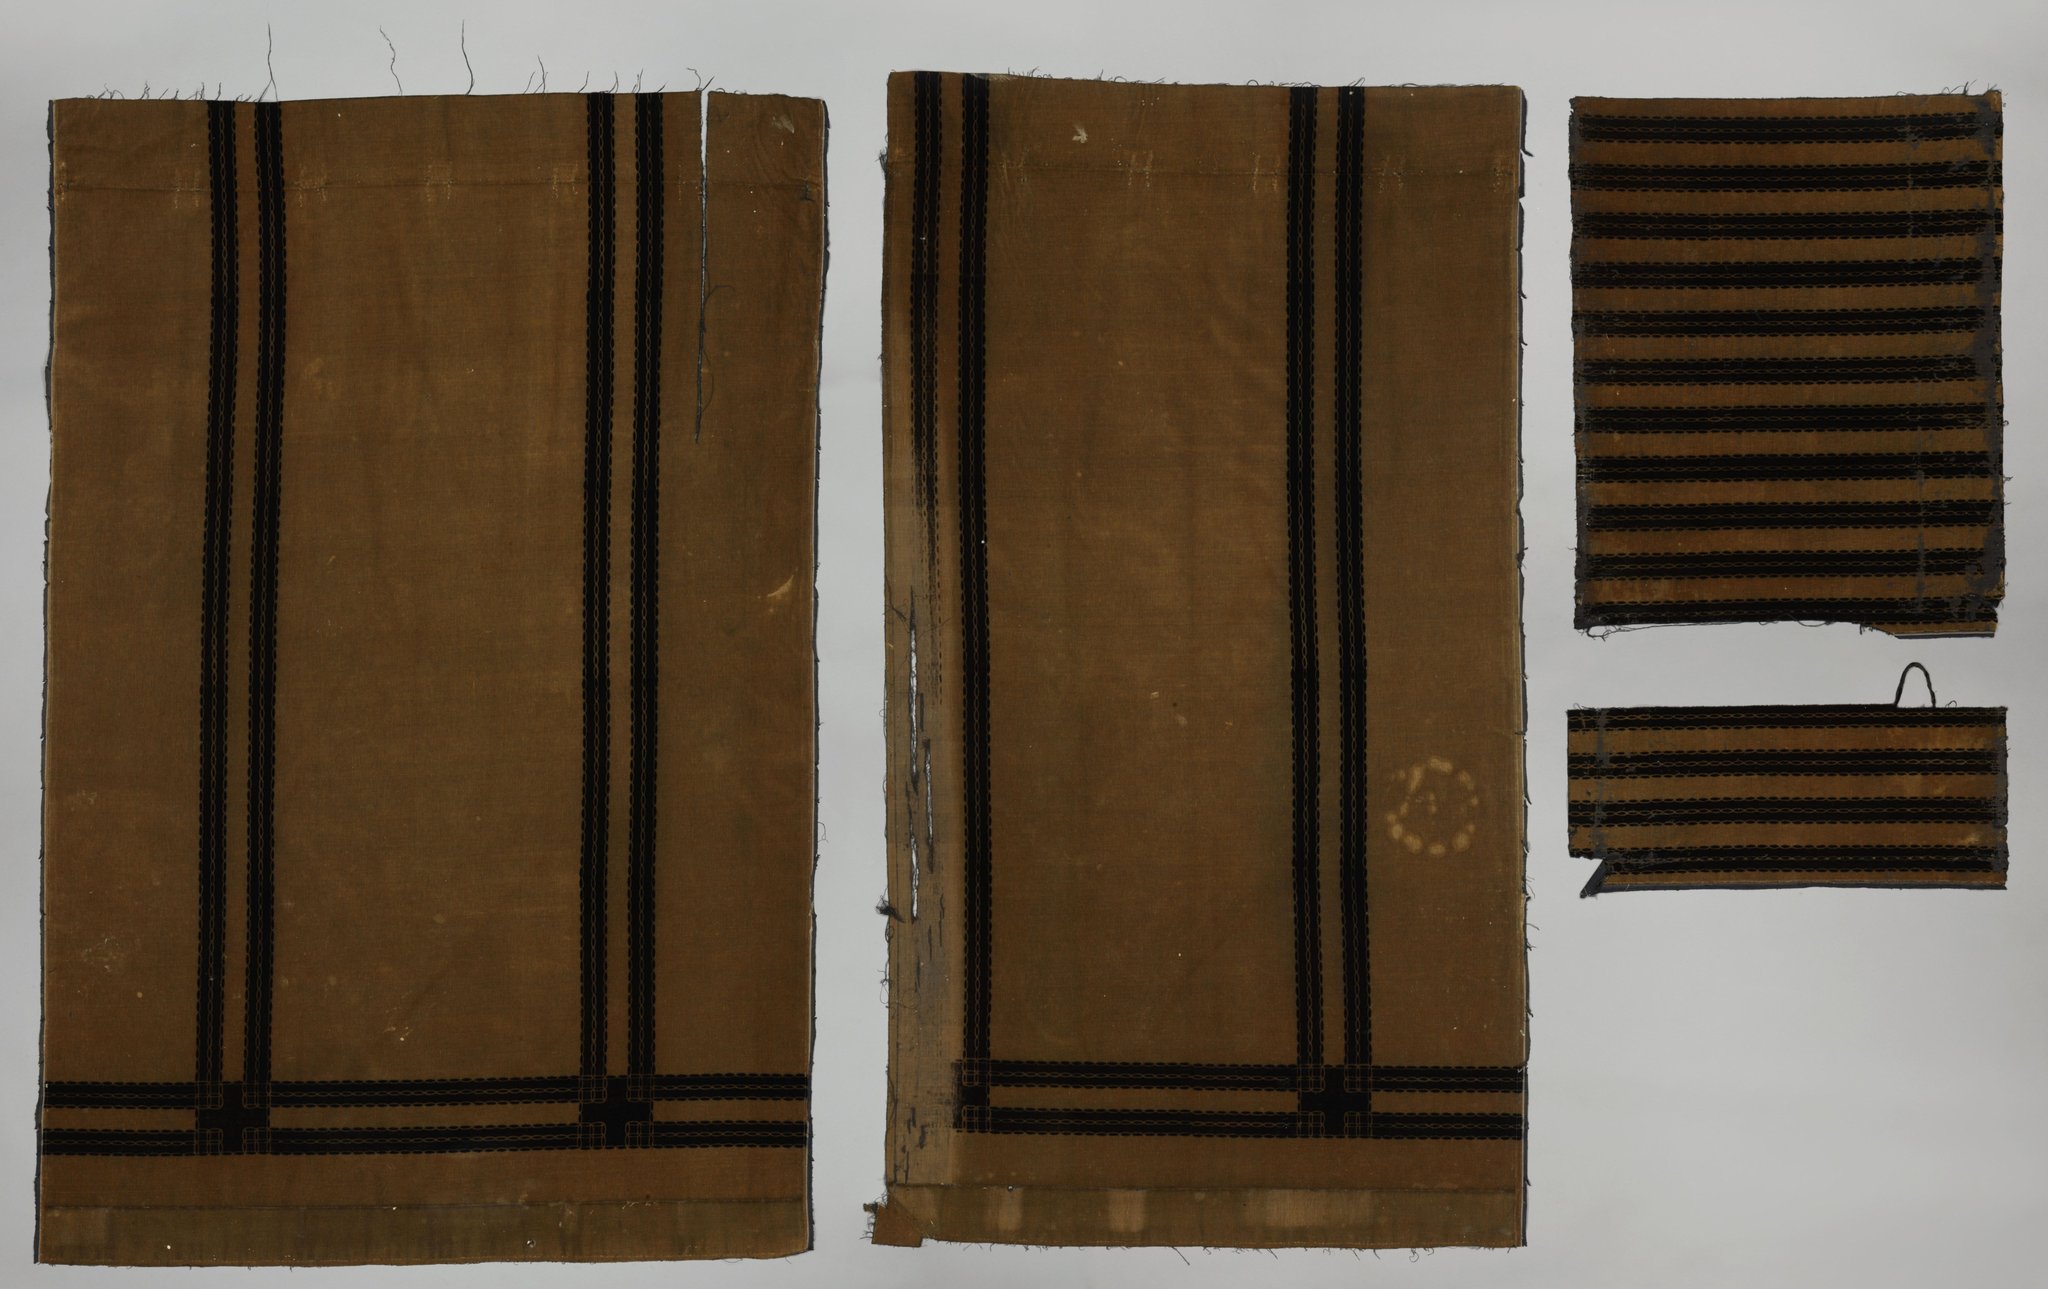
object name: bekledingsstof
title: Fragment bekledingsstof van bedrukte trijp met zwarte banden met kettingpatroon op een olijfgroene grond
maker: Anonymous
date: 1910-1920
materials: cotton, textile, hair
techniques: printing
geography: netherlands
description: Fragment bekledingsstof van bedrukte trijp. Op een olijfgroene grond lopen zwarte banden met kettingpatroon. Trijpgeweven met een v-binding.